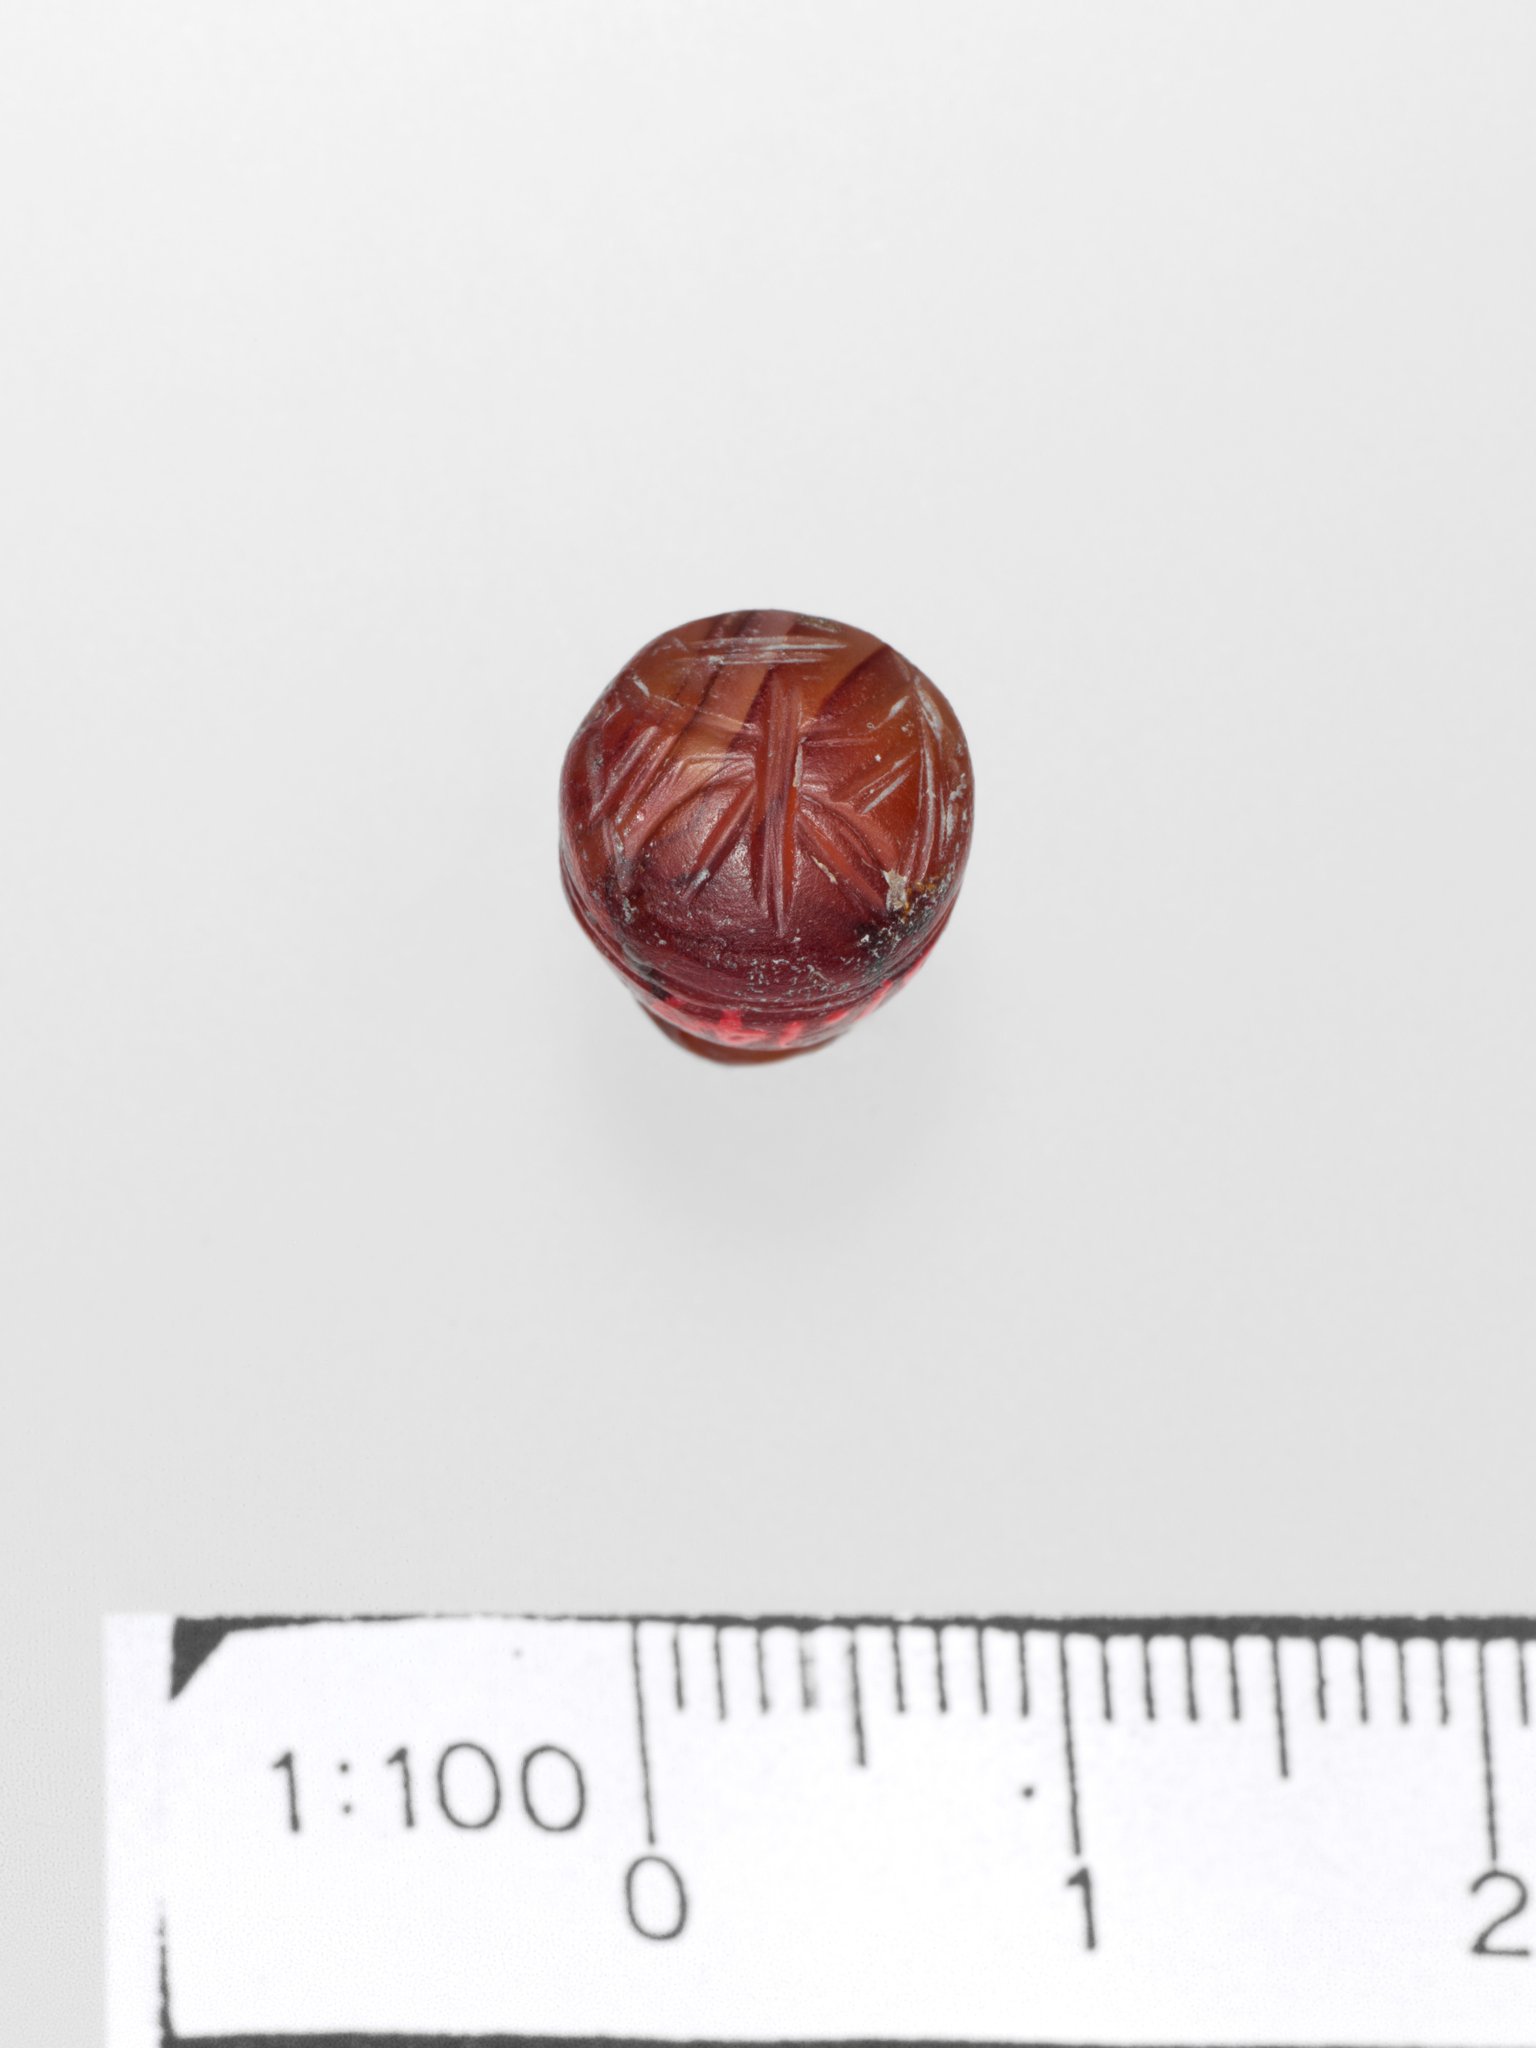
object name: seal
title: Carnelian bell-shaped stamp seal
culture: minoan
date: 1750-1600 BCE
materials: gemstone